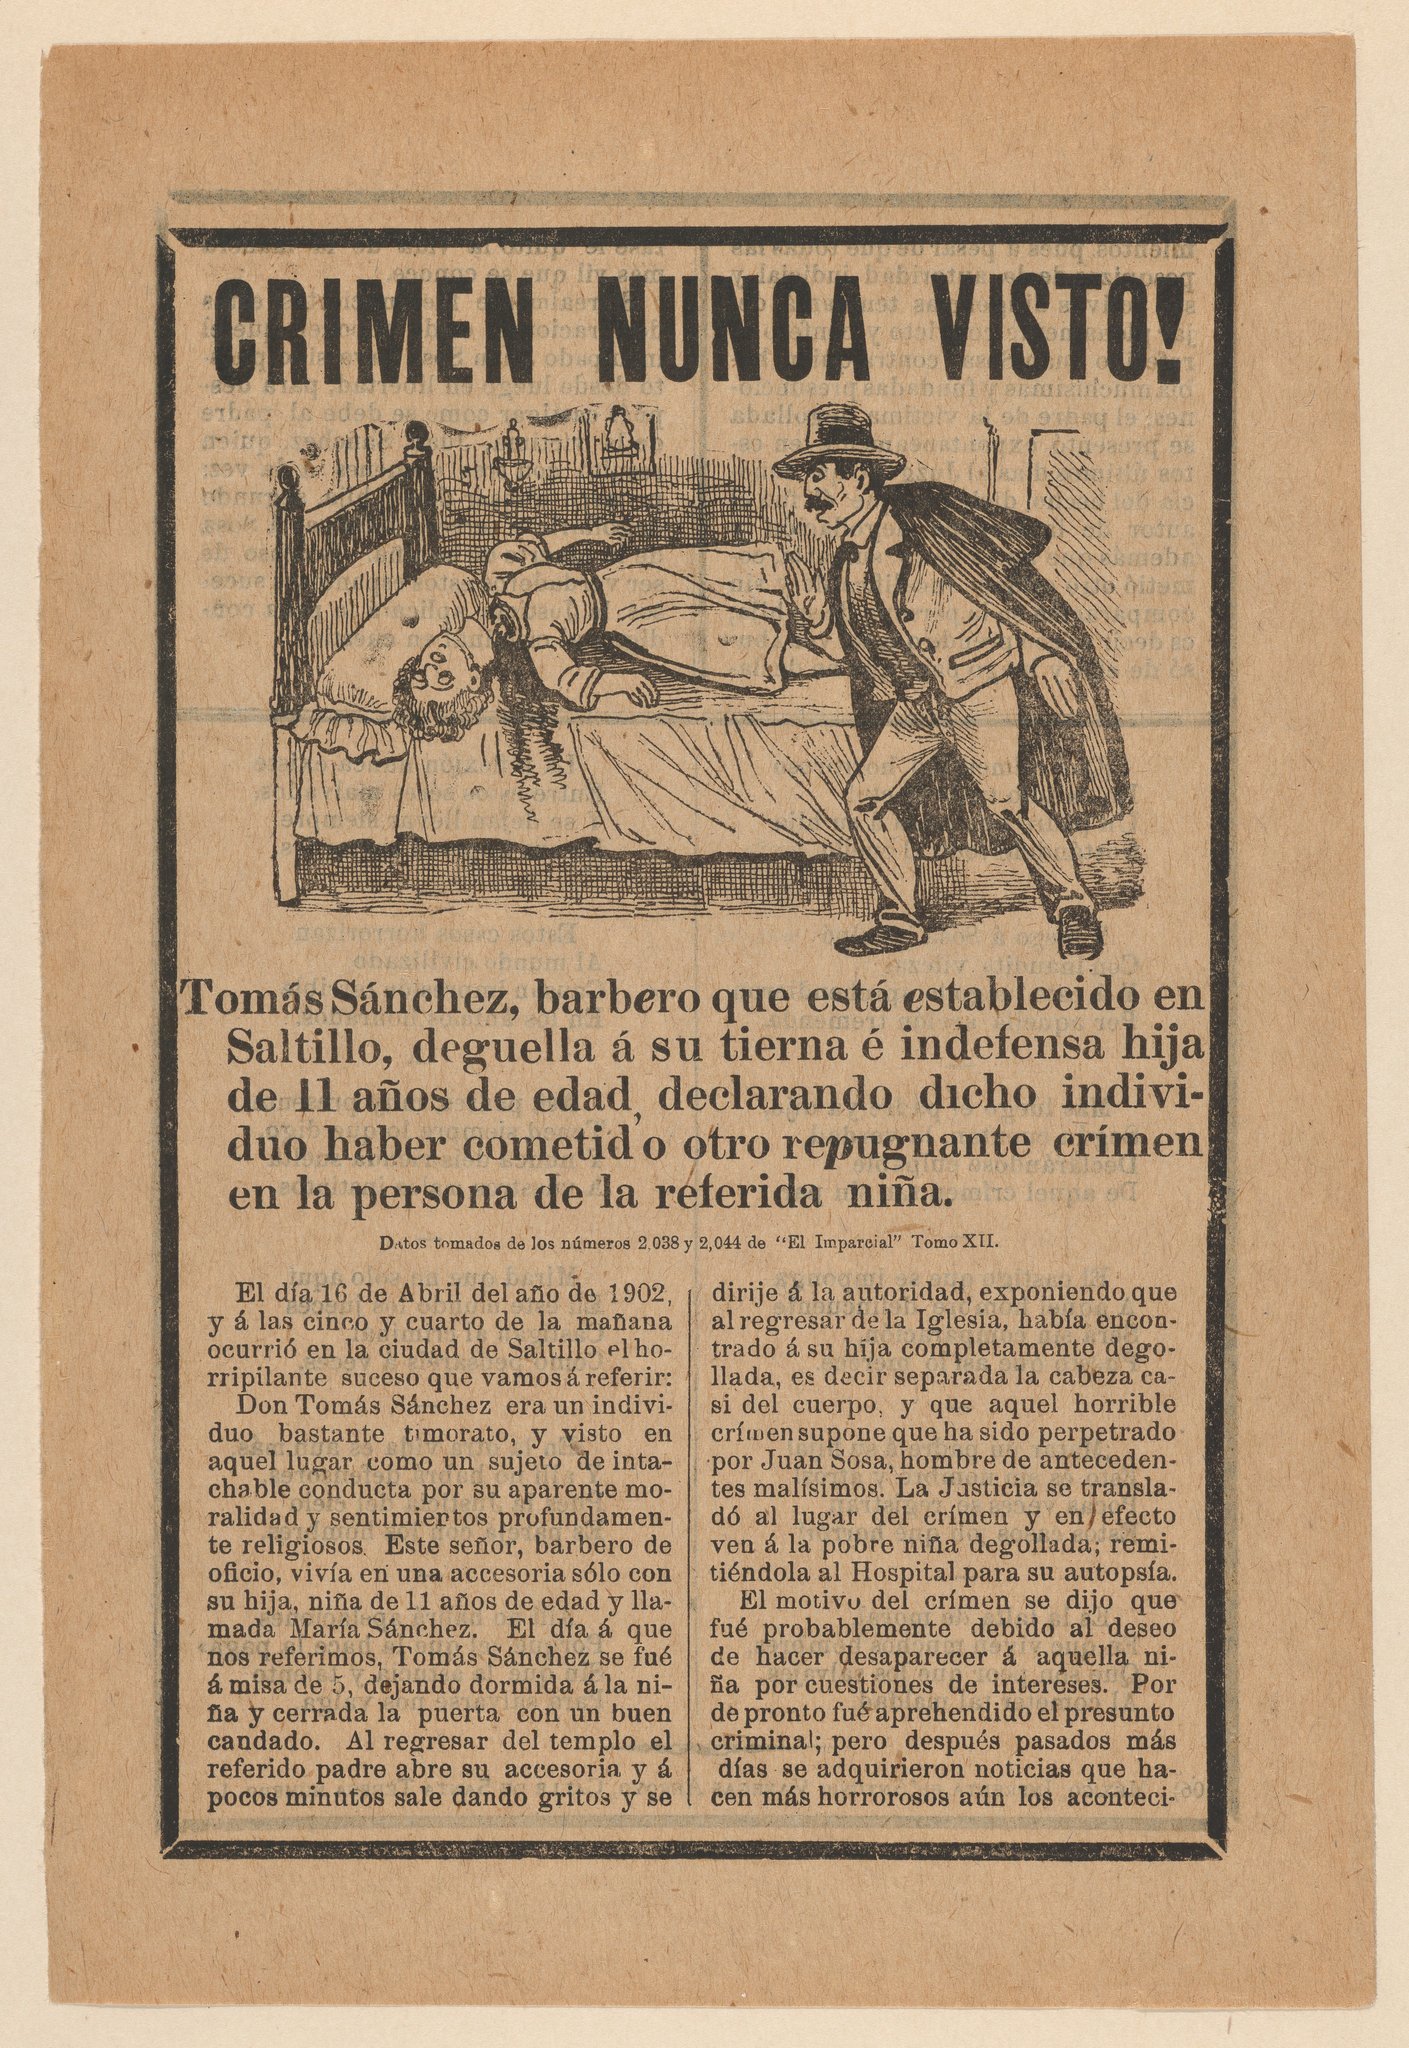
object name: print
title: Broadsheet relating to a young girl who was beheaded in April 16, 1902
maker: josé guadalupe posada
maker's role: artist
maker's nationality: mexican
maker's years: 1852-1913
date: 1902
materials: paper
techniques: letterpress, lithography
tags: girls,fathers